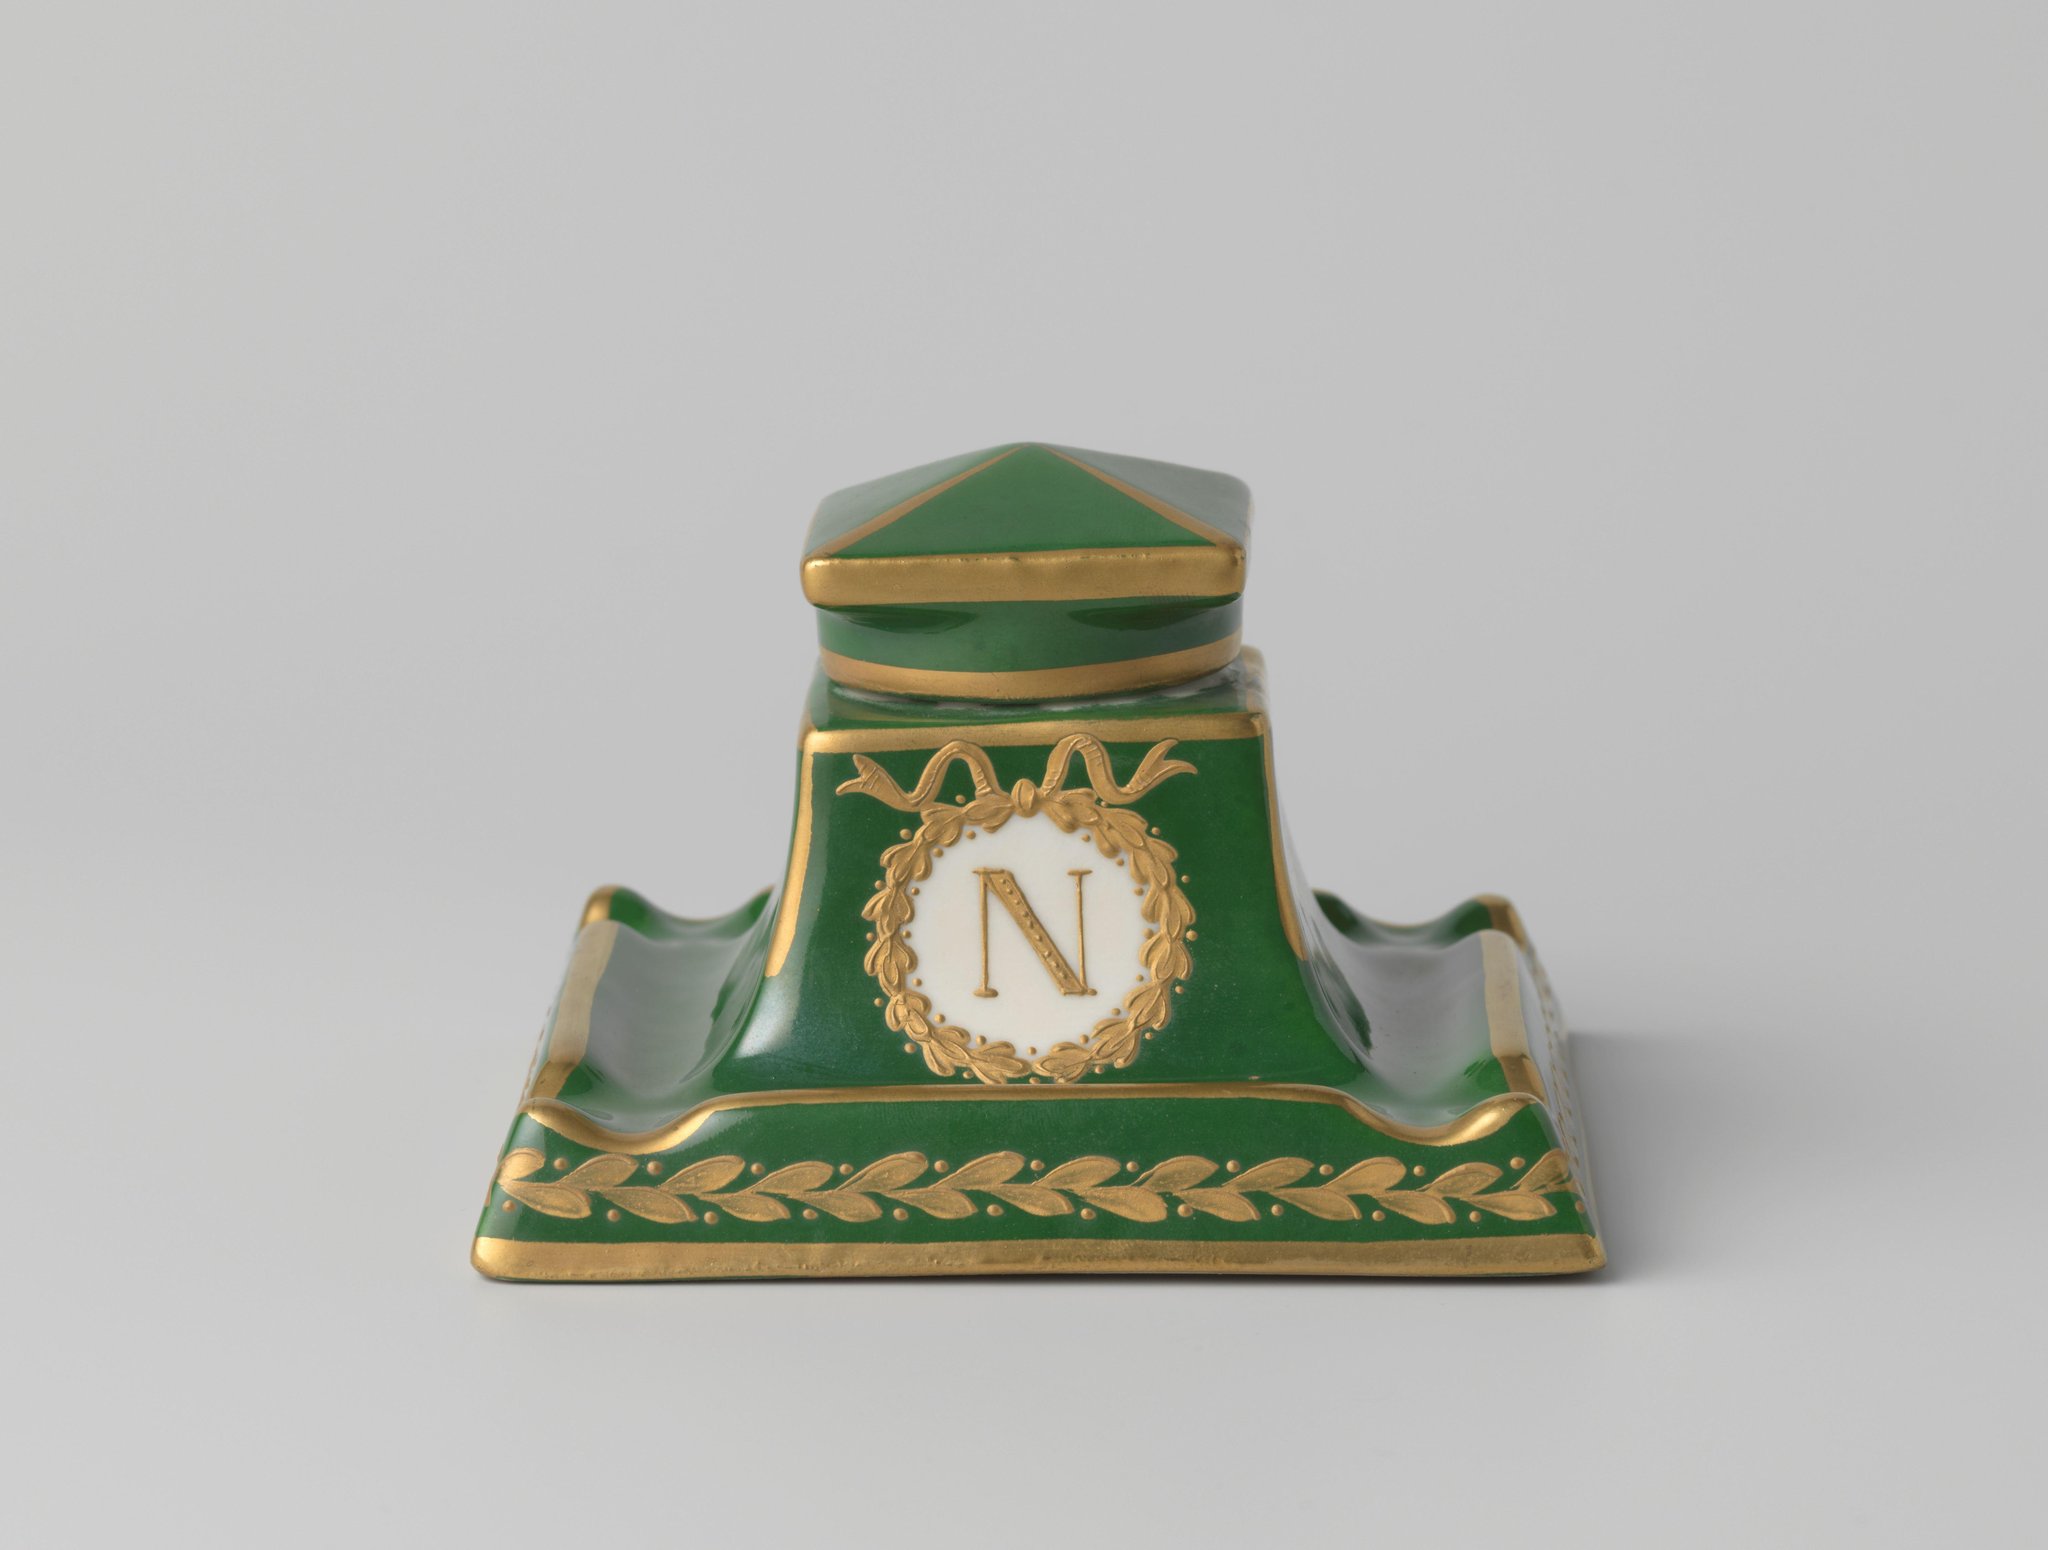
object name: inkwell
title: Cover of an ink well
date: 1800-1824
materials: glaze, gold, paint, porcelain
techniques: firing, forming, gilding, vitrification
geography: sèvres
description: Deksel van een vierkante inktpot van porselein, beschilderd op het glazuur in groen en goud. De deksel is rond met een lage, piramidevormige bovenzijde. Versierd met groen waarop gouden lijnen.